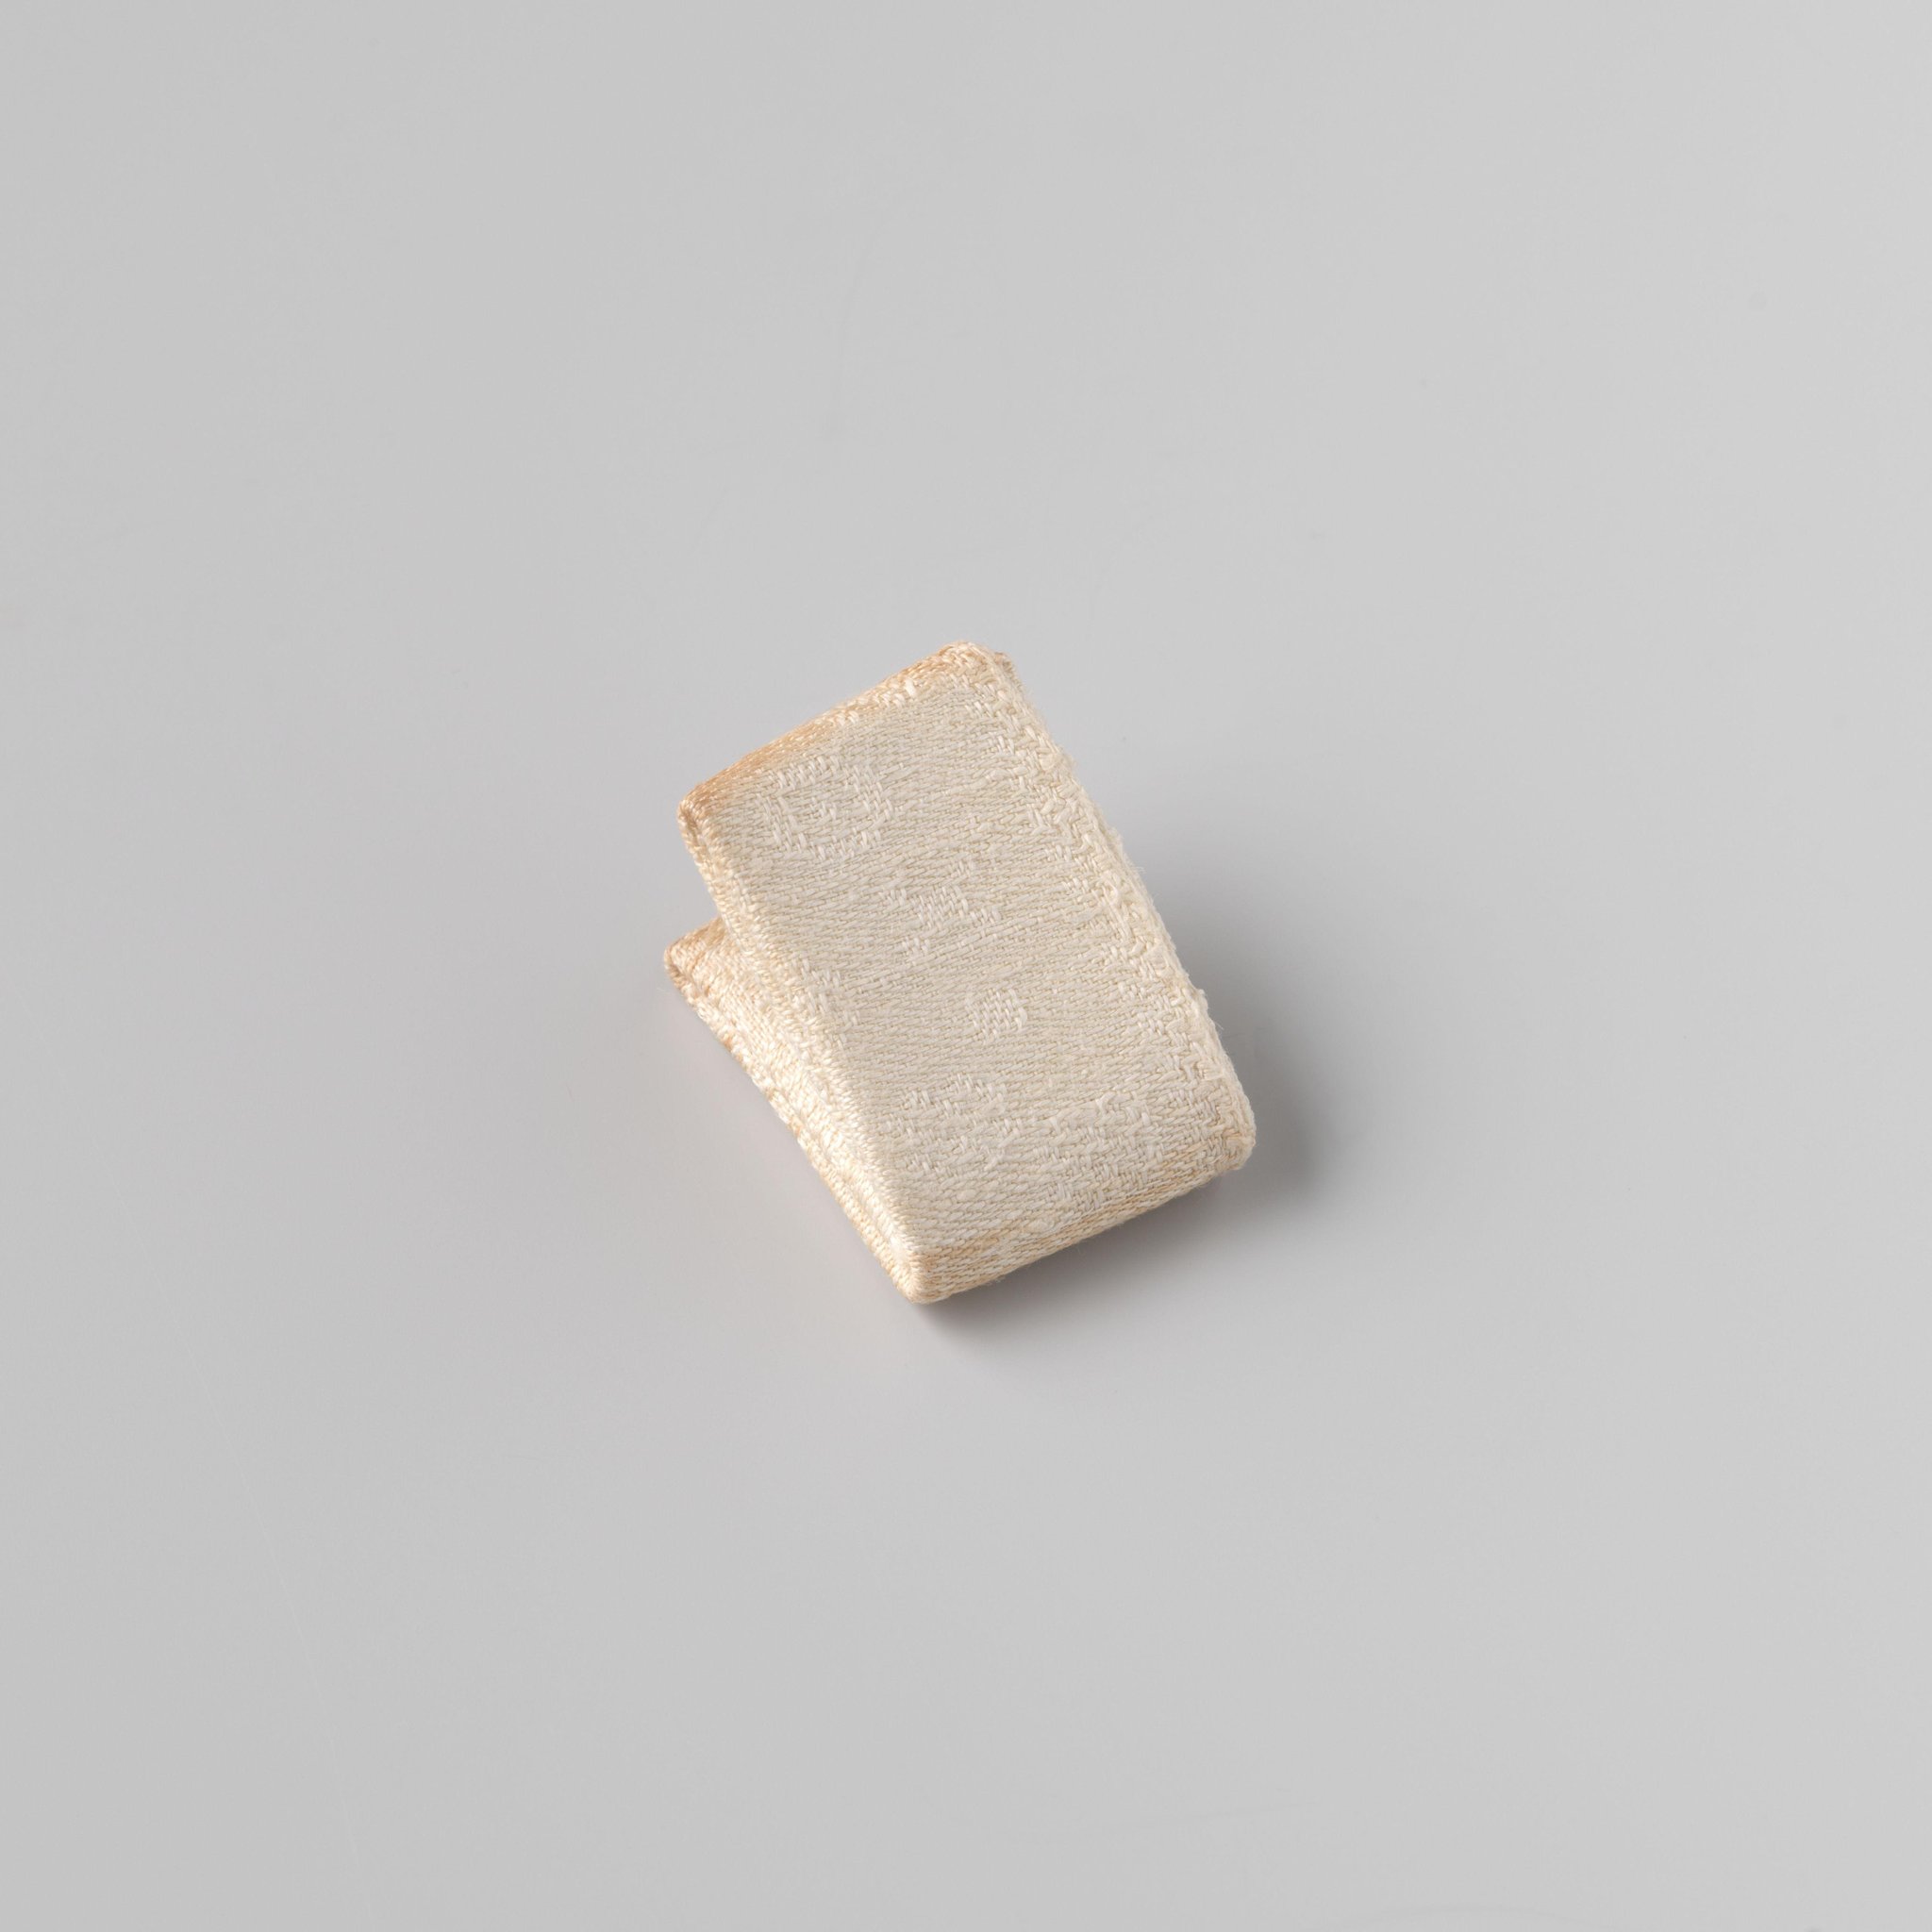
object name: dwaal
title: Linnen servet van damastweefsel, met centraal ingeweven monogram BO, waar boven en onder een vogel met opgeheven poot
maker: Anonymous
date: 1690-1710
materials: linen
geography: amsterdam